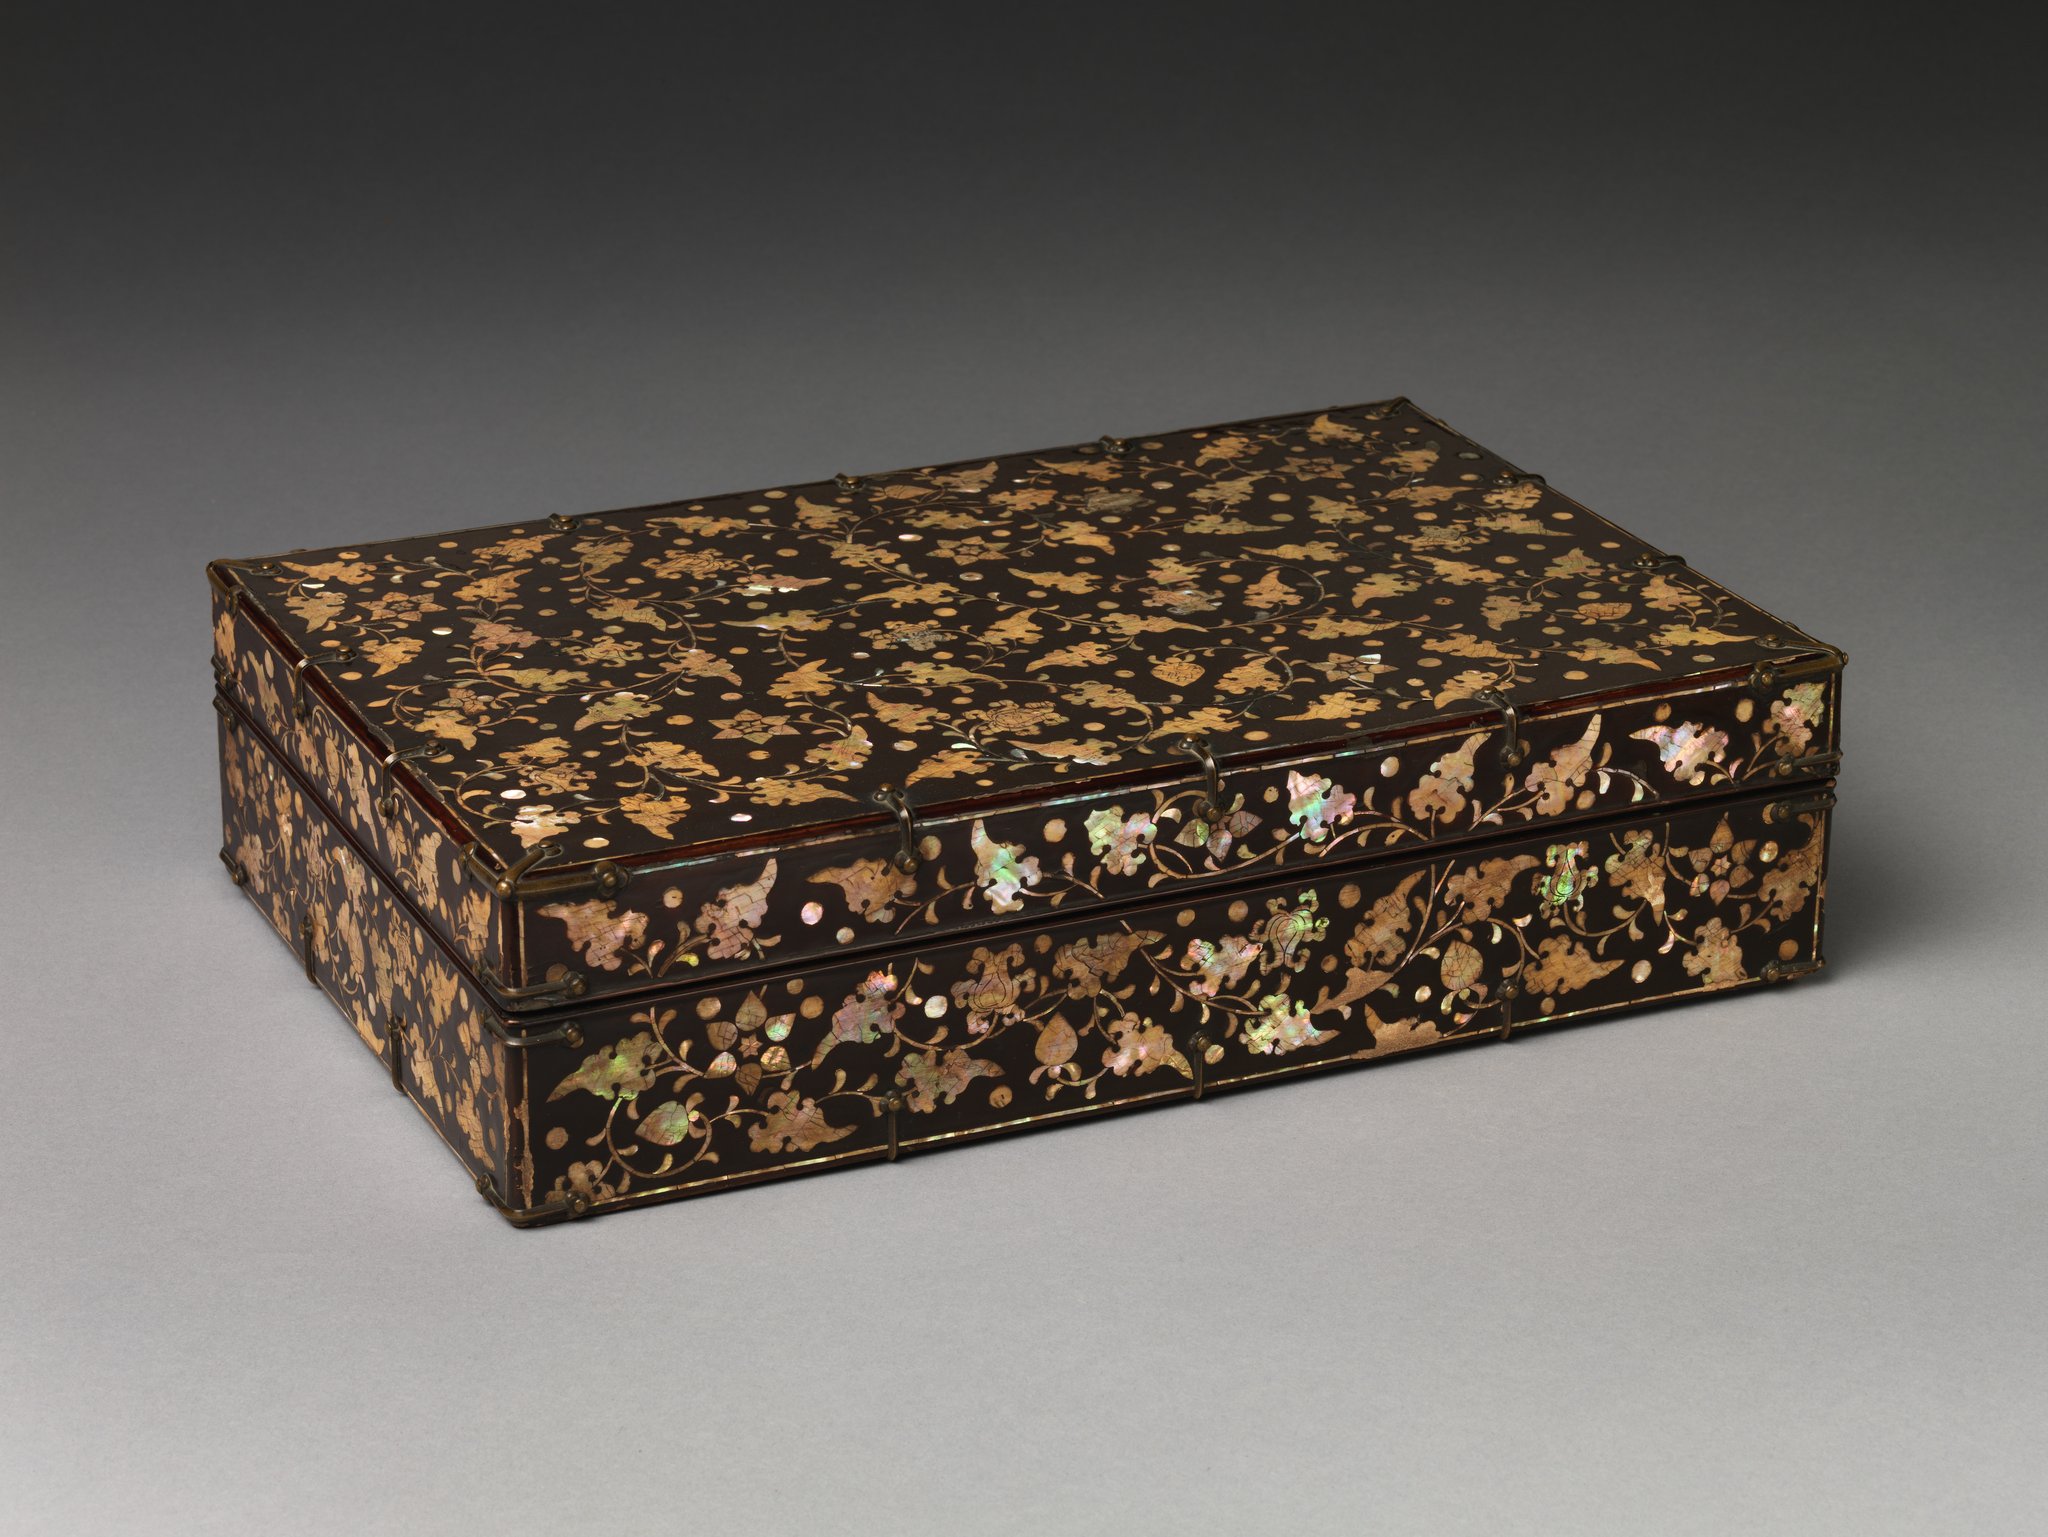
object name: stationery box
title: Stationery box decorated with peony scrolls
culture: korean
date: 1401-1600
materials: brass, lacquer, mother of pearl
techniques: inlay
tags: peonies